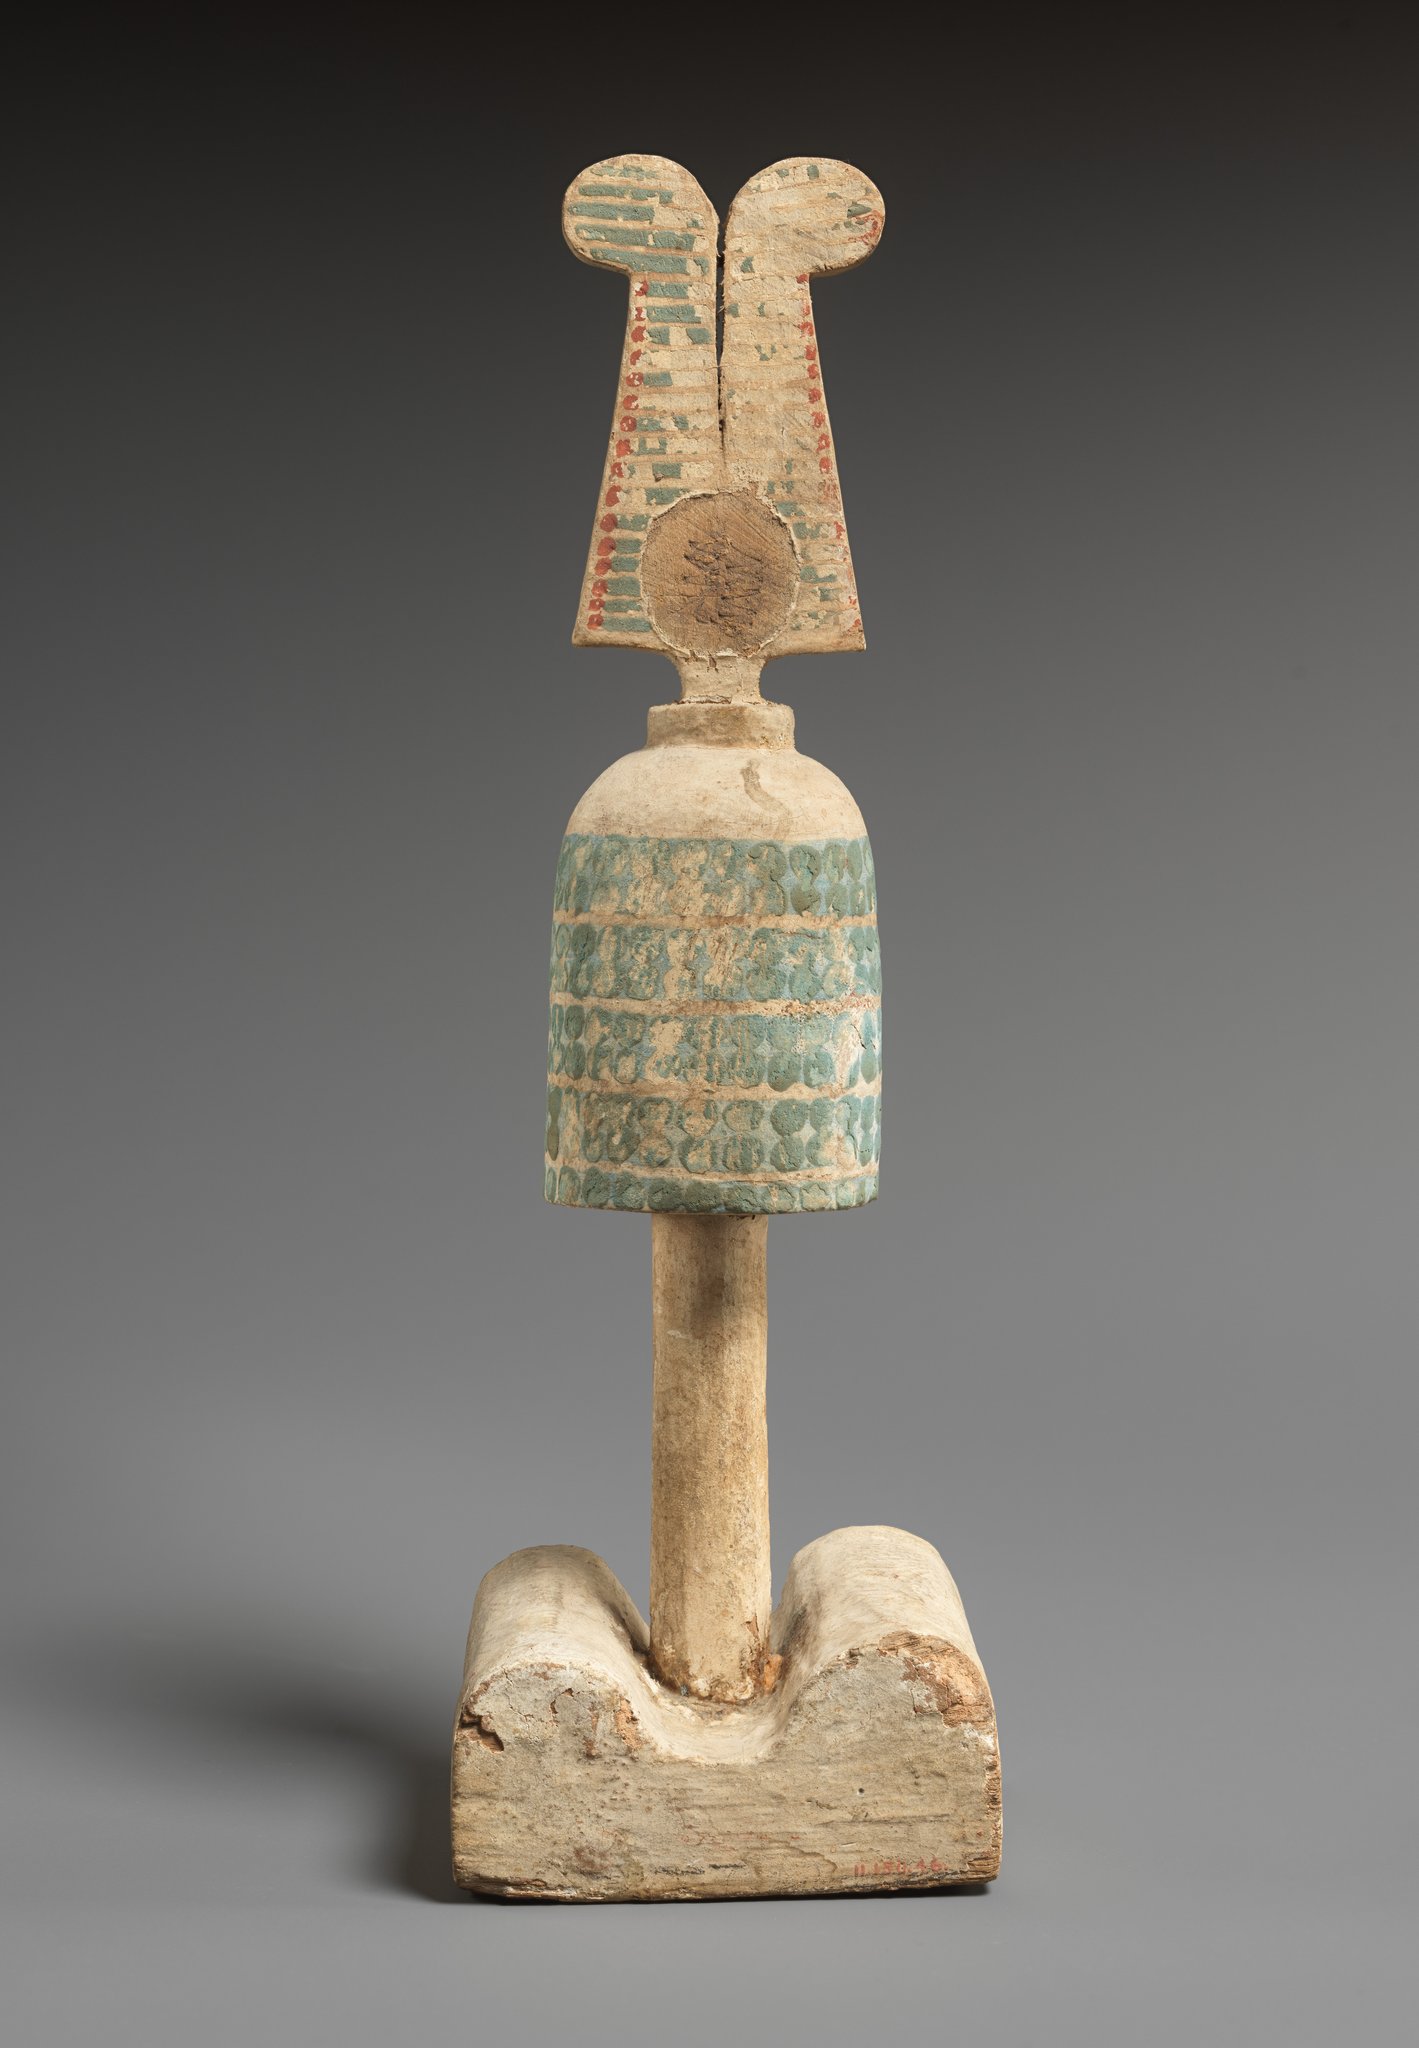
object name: abydos fetish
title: Ta-wer emblem (Abydos Fetish)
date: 1295 BCE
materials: paint, wood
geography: egypt